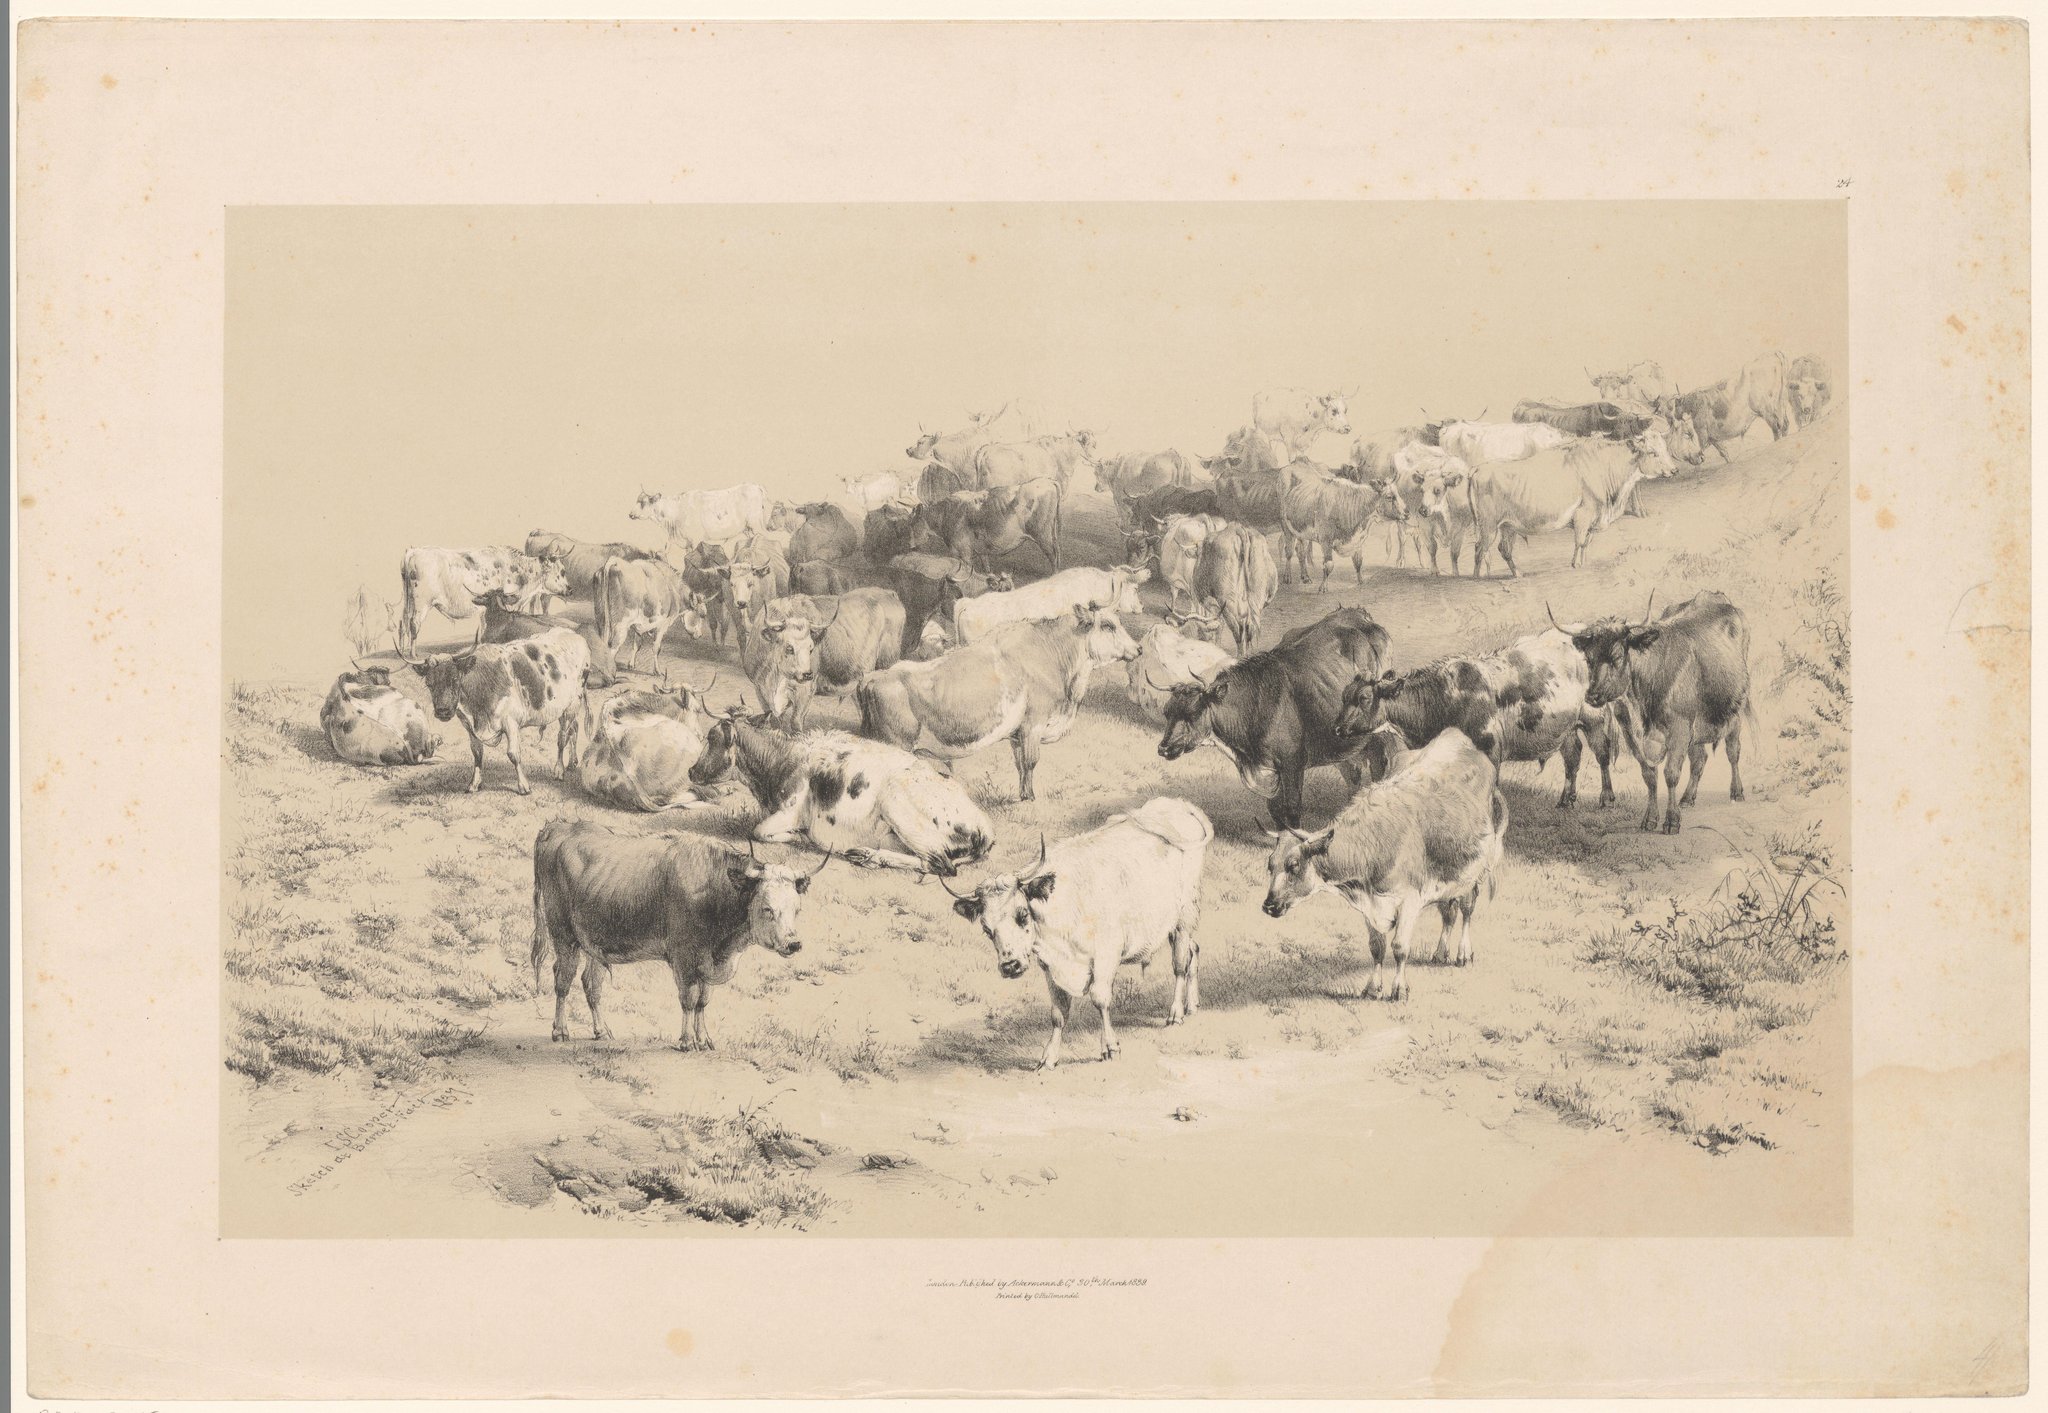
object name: print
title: Kudde runderen te Barnet Fair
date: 1839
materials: paper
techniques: tone lithography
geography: london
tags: bovine cattle, england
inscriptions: collector's mark: Lugt 2228